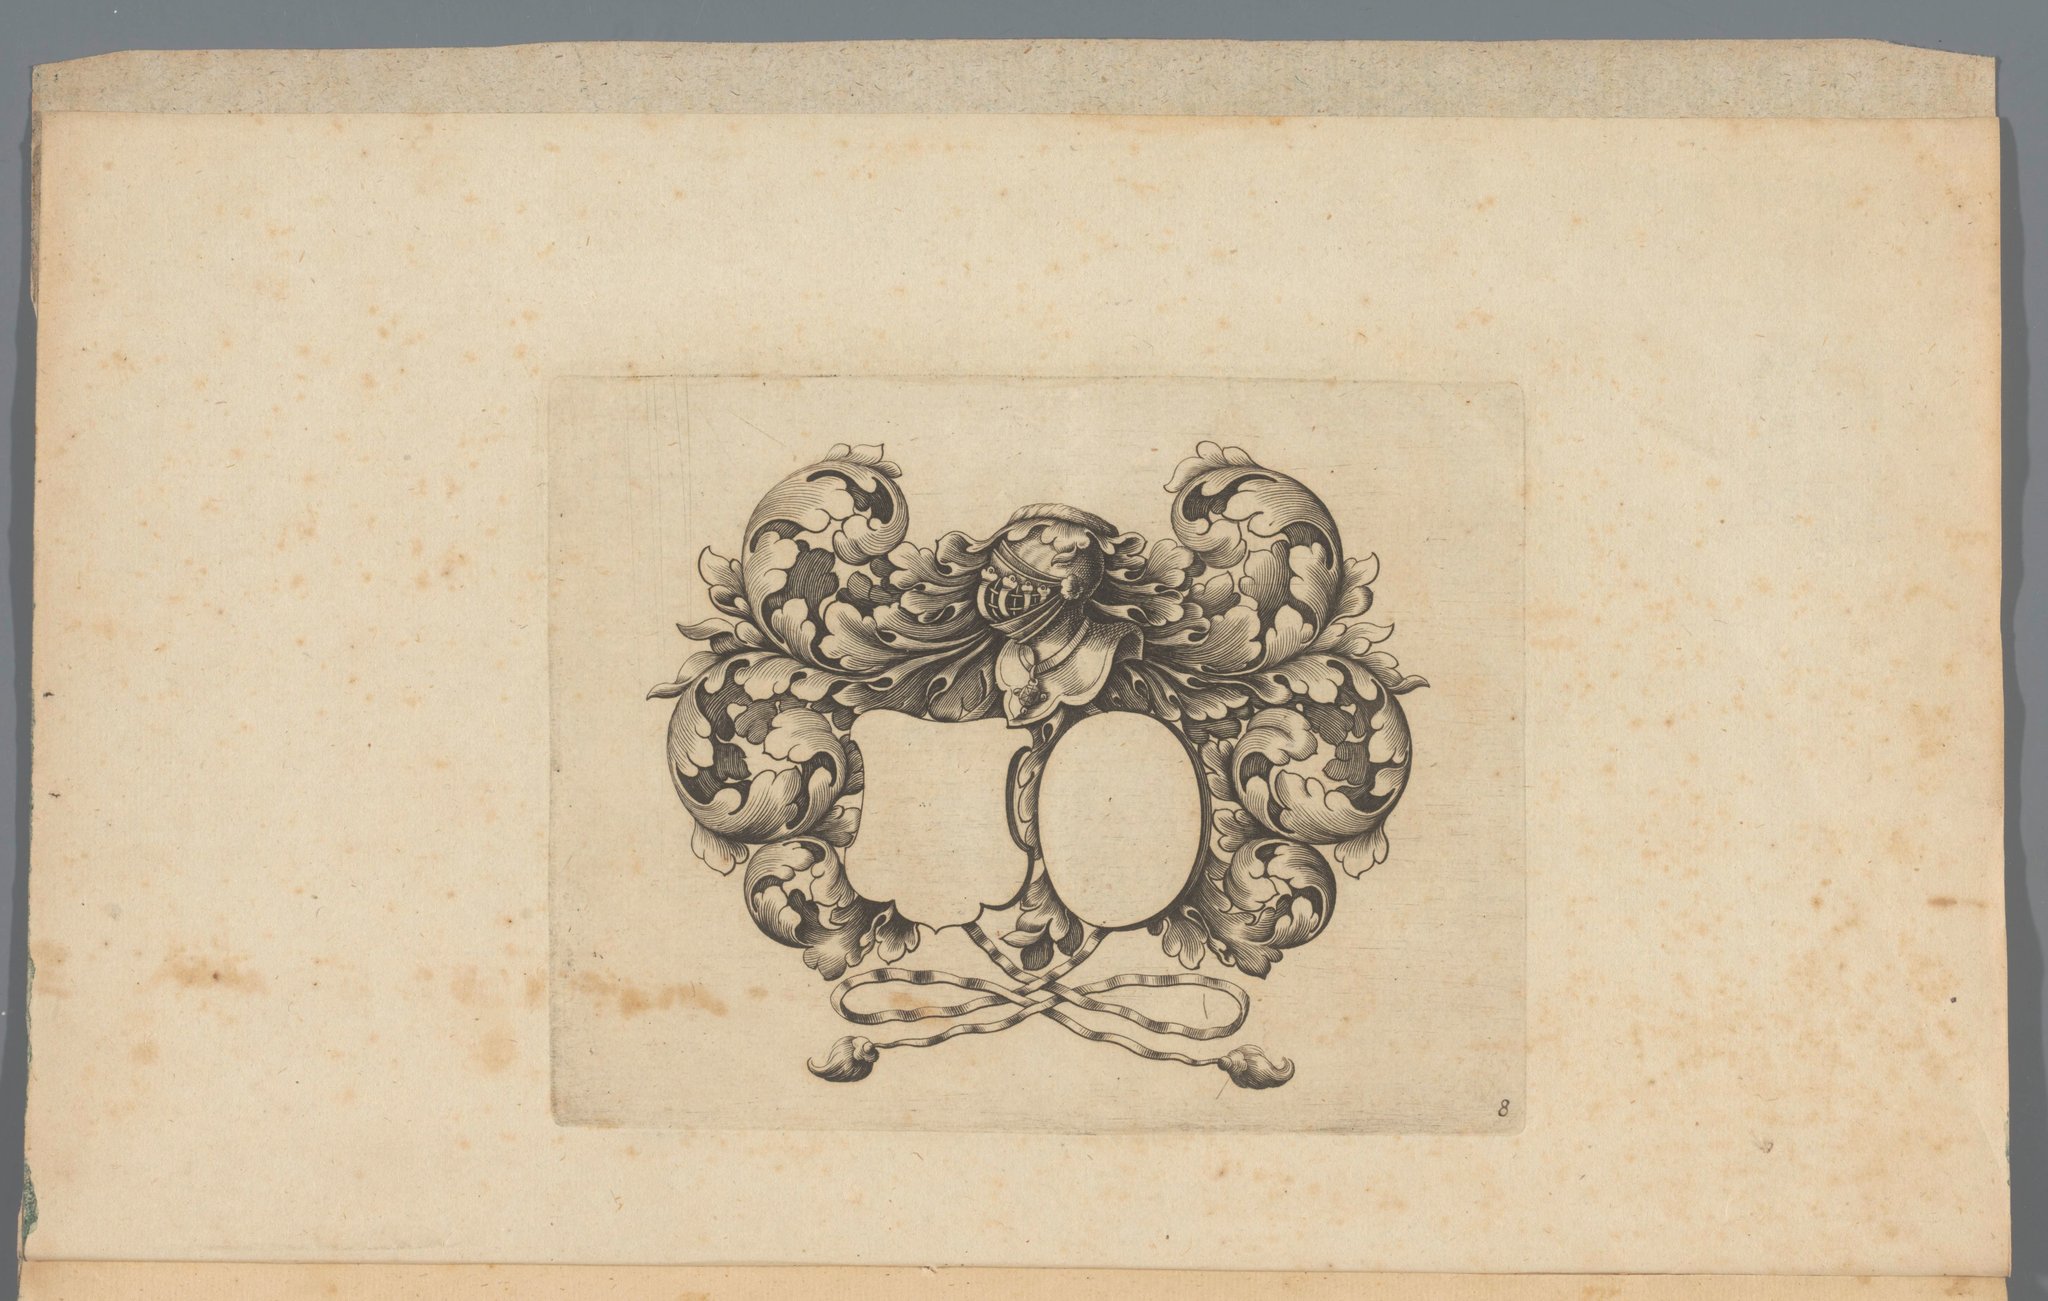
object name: print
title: Cartouche voor wapenschild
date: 1630-1680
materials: paper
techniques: engraving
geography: netherlands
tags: armorial bearing, heraldry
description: Prent nr. 8 in een bundel van acht genummerde prenten met cartouches voor wapenschilden, eerste blad getiteld "Nieuwe Wapen Schilde". Met een touwtje samengebonden in een kaft van 19e-eeuws sierpapier.